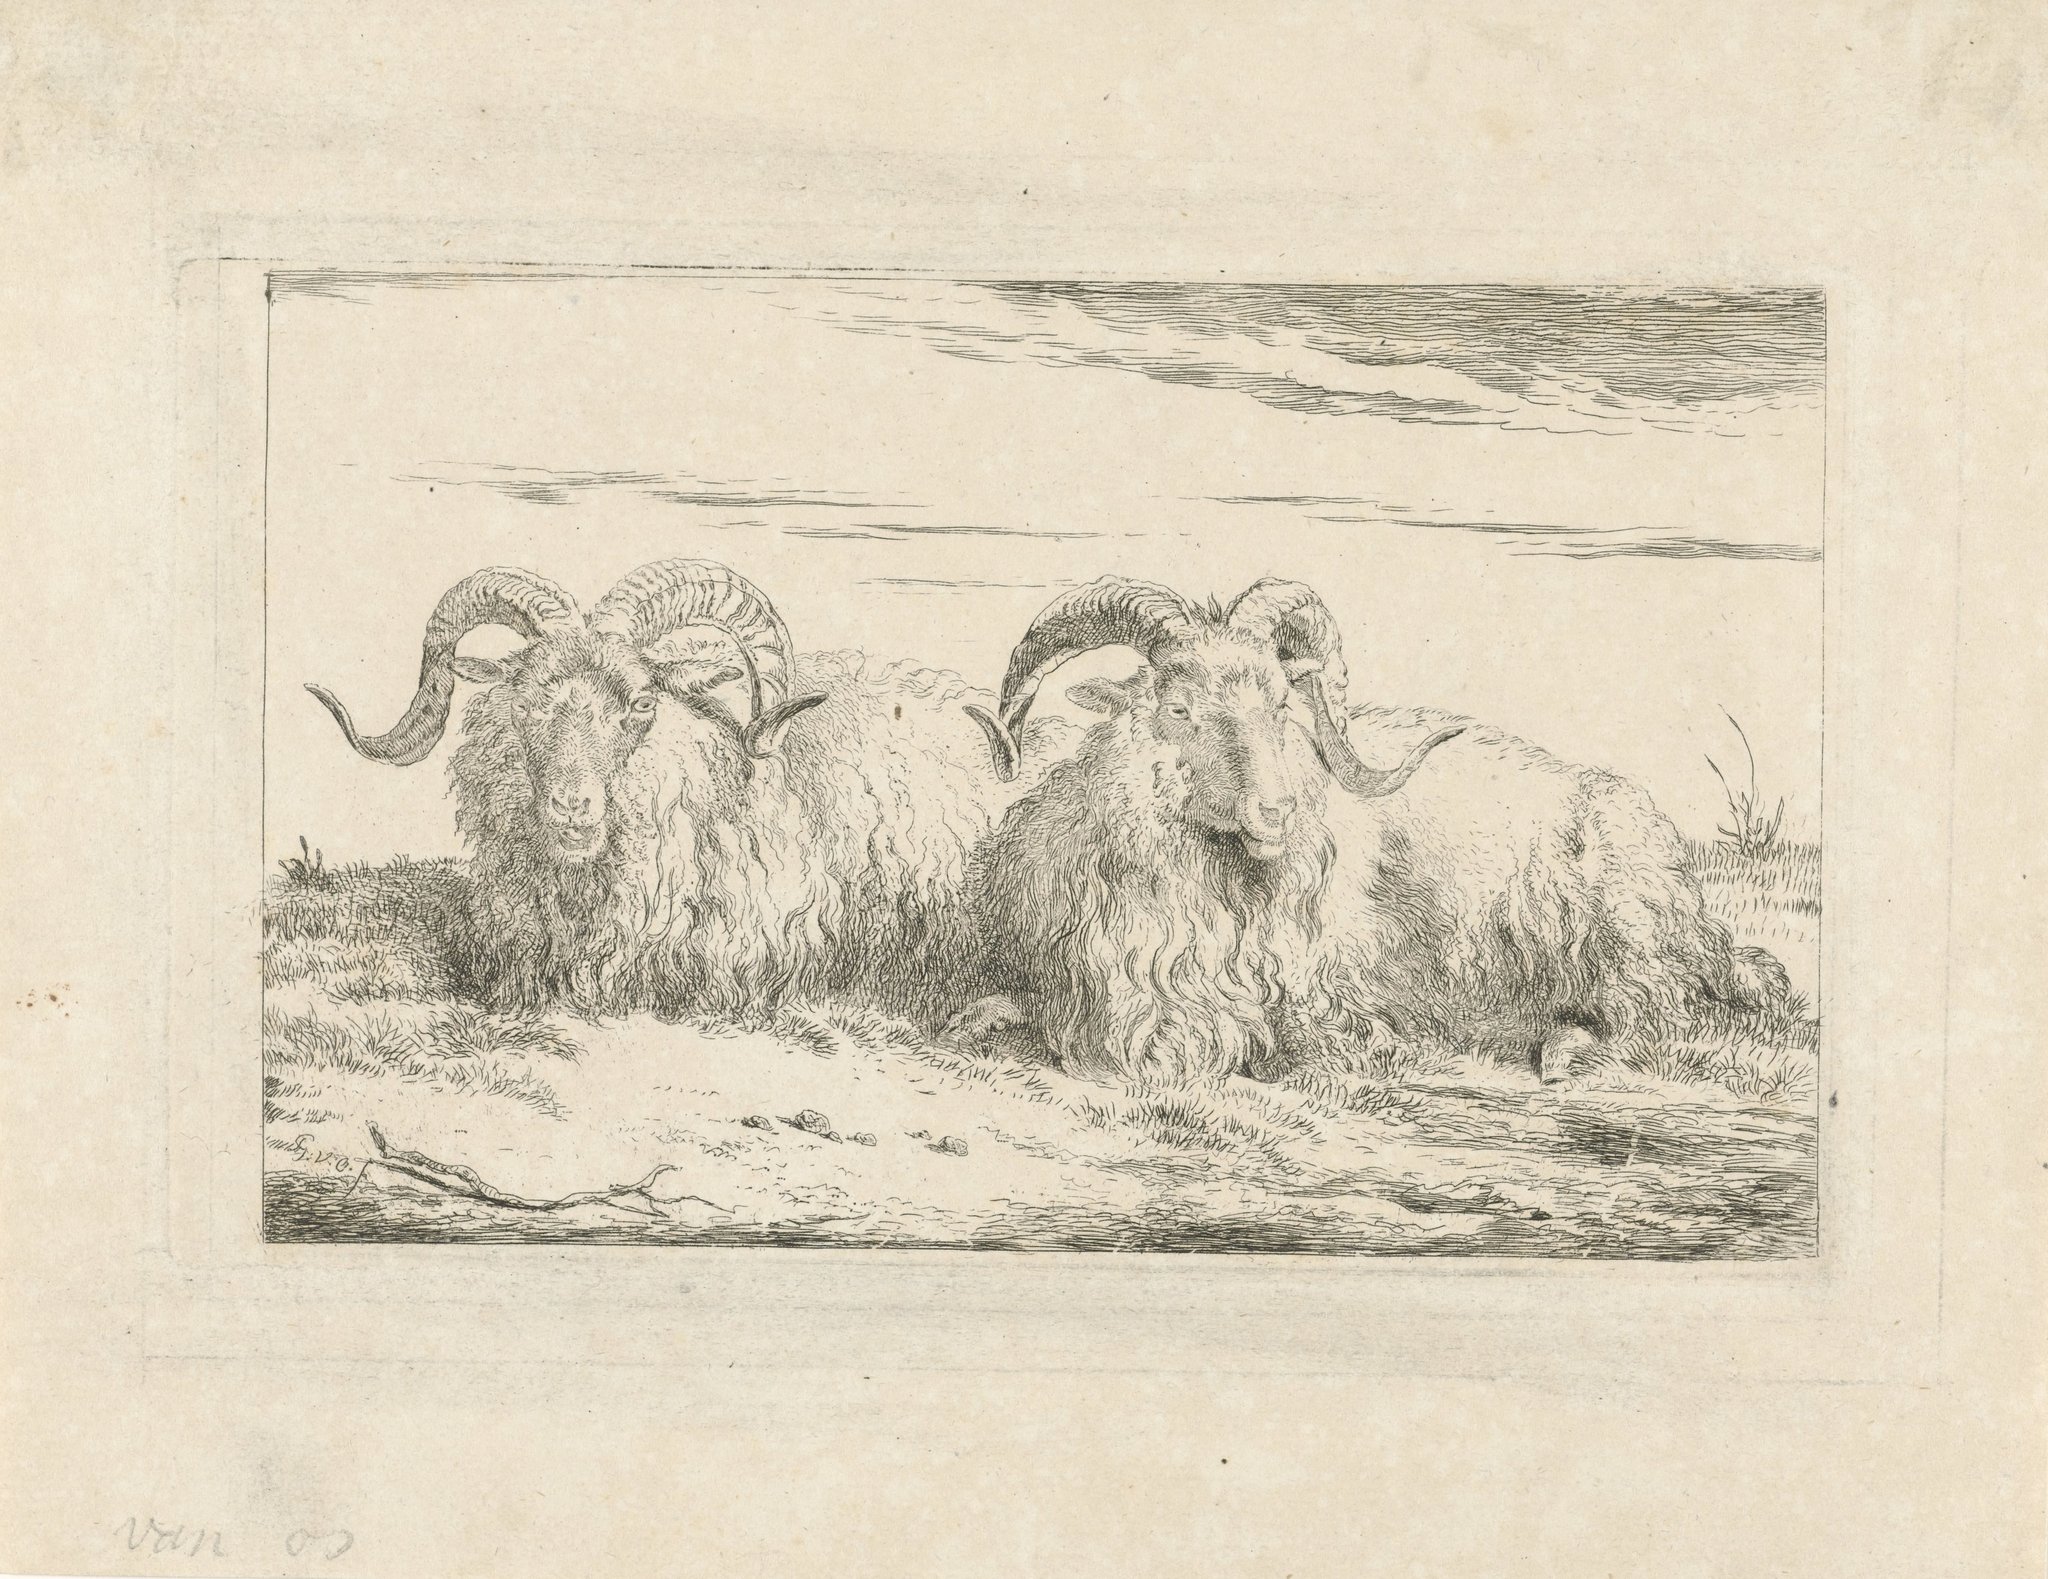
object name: print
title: Schapen en geiten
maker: pieter gerardus van os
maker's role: draughtsman, painter, print maker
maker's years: 1776-1839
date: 1791-1839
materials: paper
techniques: etching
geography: netherlands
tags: ram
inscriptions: collector's mark: Lugt 2228